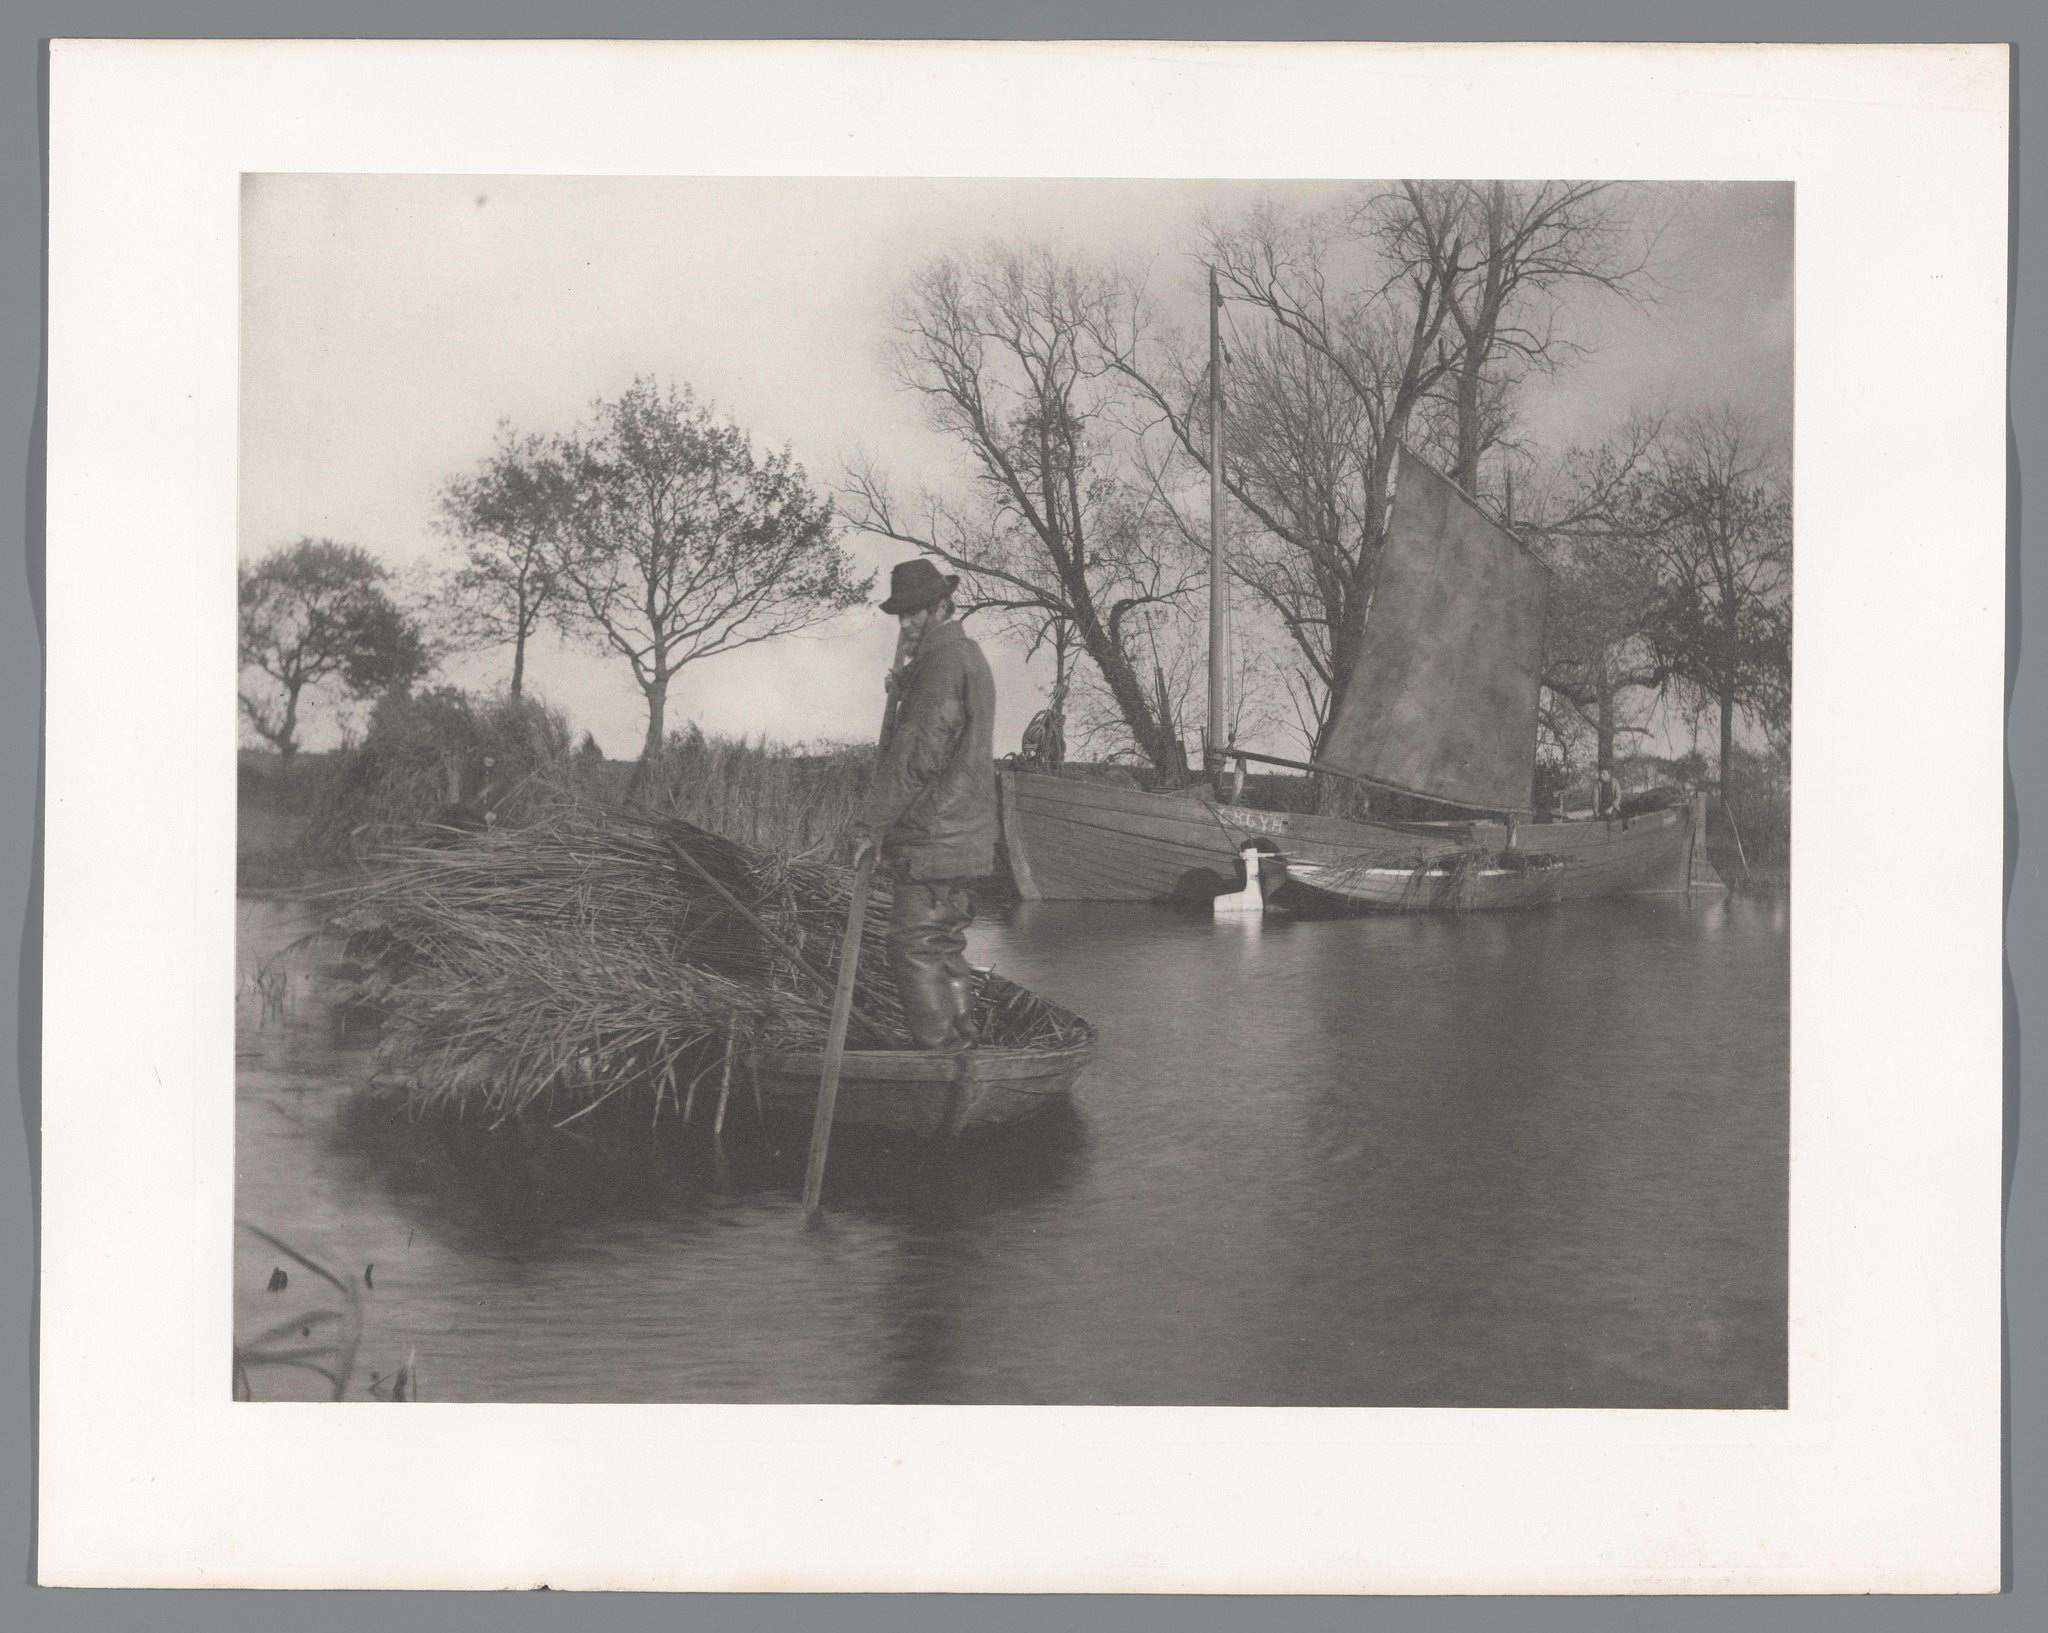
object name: photograph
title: Man op een roeiboot met twijgen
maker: peter henry emerson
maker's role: fotograaf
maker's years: 1856-1936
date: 1885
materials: paper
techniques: platinum process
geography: england